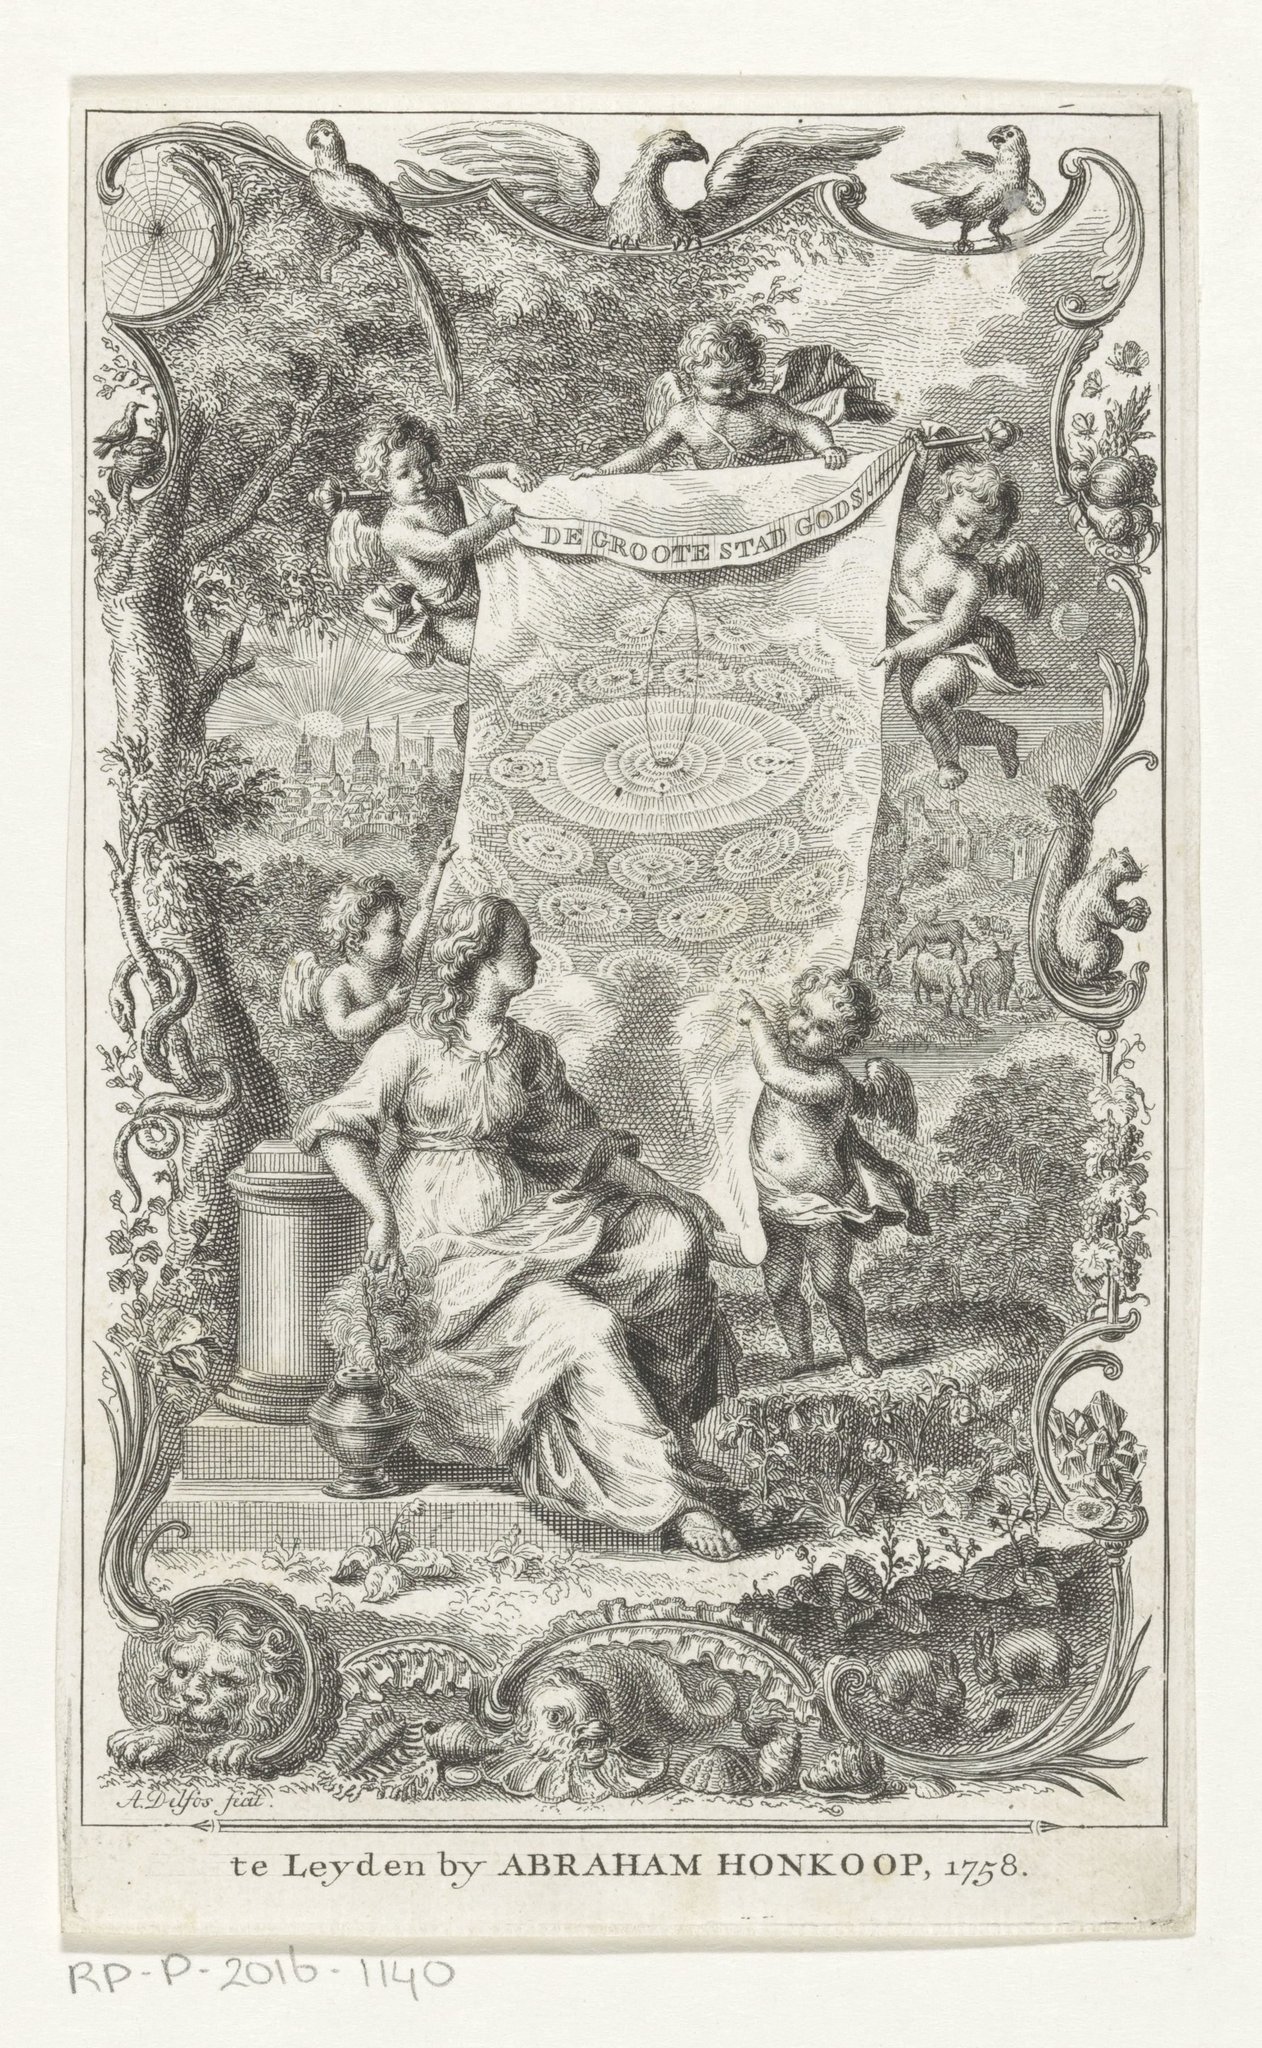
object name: print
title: Titelpagina voor: Hermannus Samuel Reimarus, De voornaamste waarheden van den natuurlyken gods-dienst, in tien verhandelingen, 1758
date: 1758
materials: paper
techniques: etching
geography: leiden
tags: the new jerusalem, the all-seeing eye, triangle with eye ~ symbol of god the father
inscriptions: collector's mark: Lugt 2228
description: Titelpagina voor: Reimarus, Hermannus Samuel. De voornaamste waarheden van den natuurlyken gods-dienst, in tien verhandelingen. Leiden: Honkoop, Abraham (I), 1758. Prent afkomstig uit een plakalbum met titelprenten, ornamenten etc. op blauw papier in 1983 uit elkaar gehaald. Volgens een notitie op verso zat de prent op p. 213 van dit album.